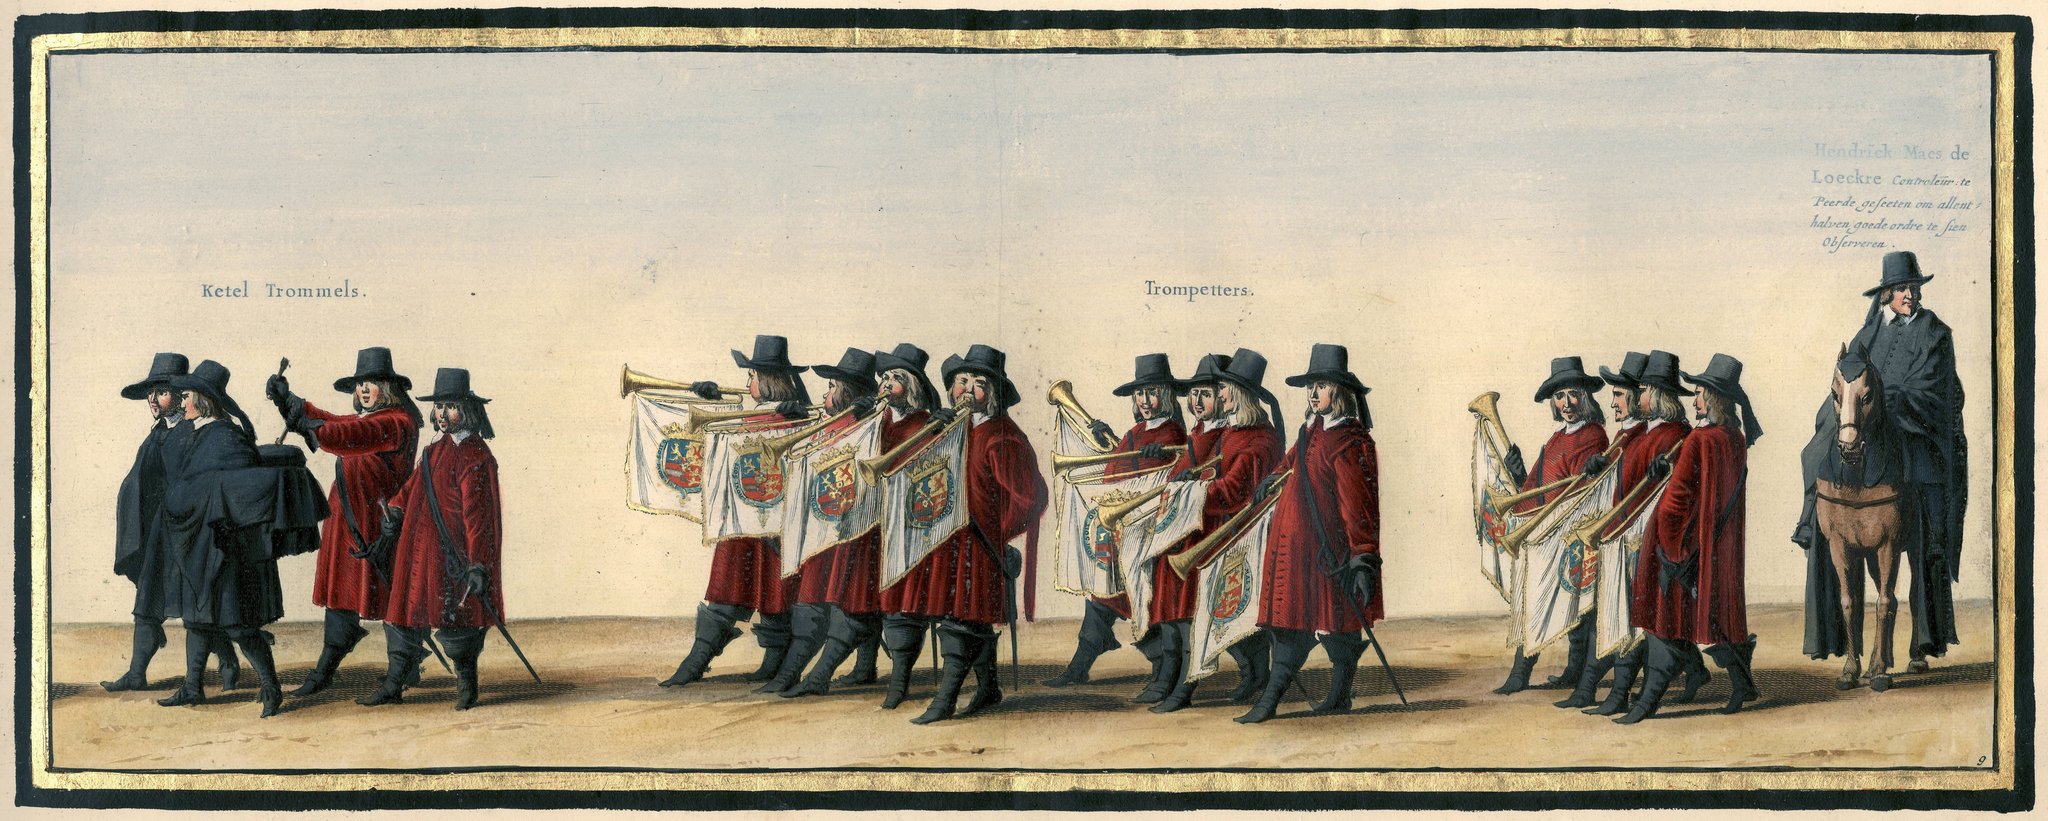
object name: print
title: De begrafenisstoet van Frederik Hendrik, plaat nr. 9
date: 1651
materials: paint, paper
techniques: colour, etching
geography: amsterdam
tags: delft, the hague, frederick henry (prince of orange)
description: De begrafenisstoet van Frederik Hendrik, plaat nr. 9 met trompetters. Ingekleurde prent in een omlijsting versierd met goud en ingeplakt in de luxe editie uit ca. 1755 van het boek 'Begraeffenisse van syne hoogheyt Frederick Henrick' van Pieter Post, uitgegeven te Amsterdam in 1651.